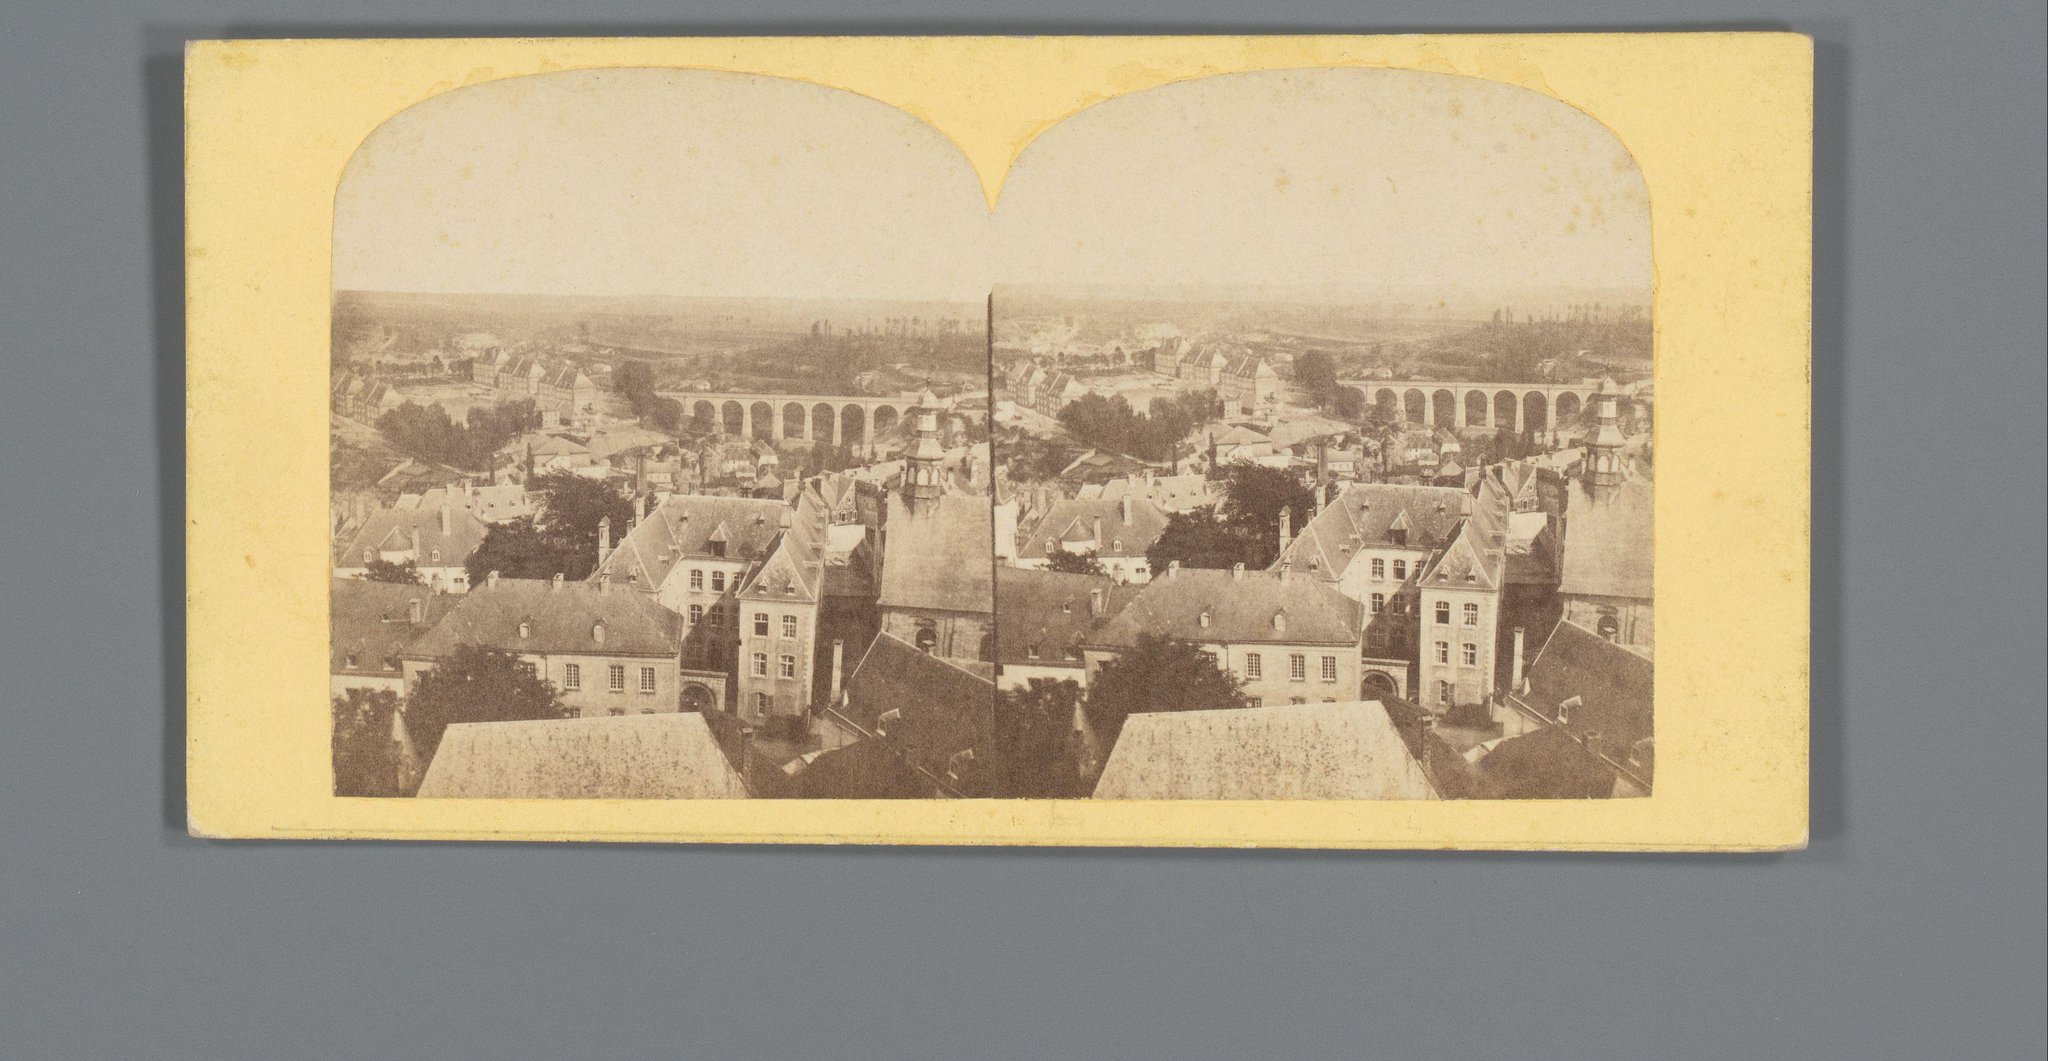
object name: stereograph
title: Gezicht op Luxemburg, gezicht vanuit vogelperspectief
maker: Anonymous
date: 1861-1870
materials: cardboard, paper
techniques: albumen print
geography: luxembourg city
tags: city-view in general; 'veduta'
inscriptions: inscription: ‘15’, number: ‘No. 22.’, collector's mark: ‘Librairie de E. HOFFMAN à Luxembourg.’